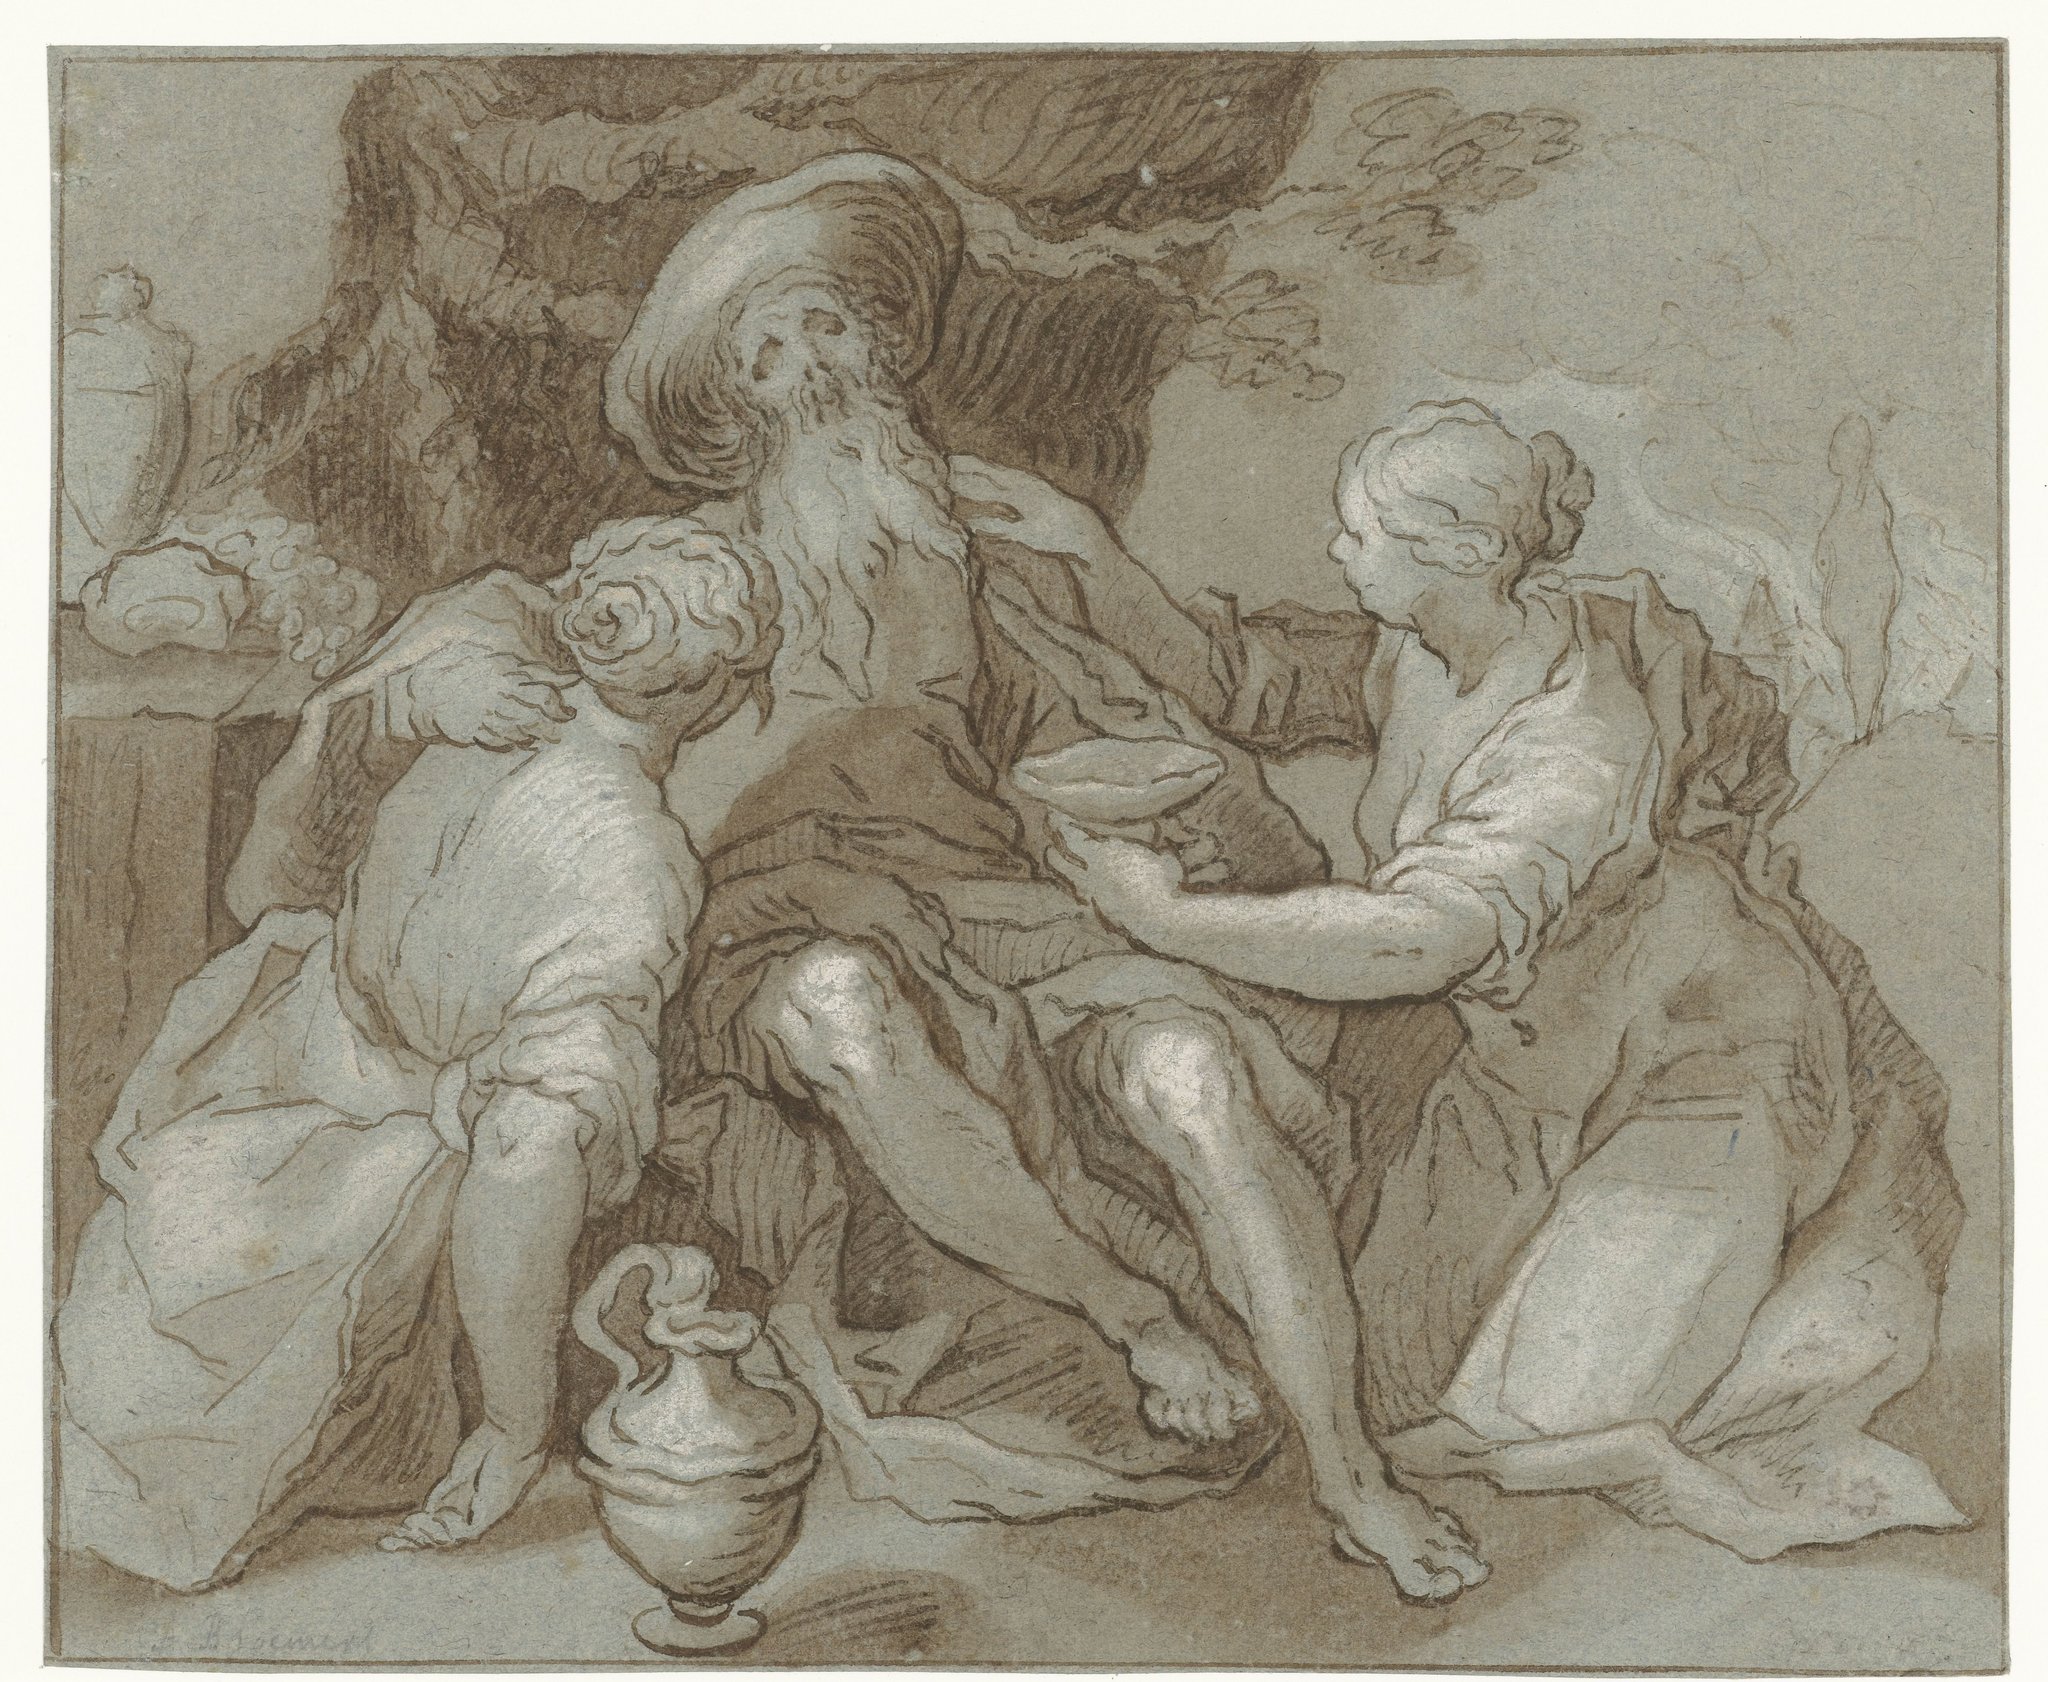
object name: drawing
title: Lot en zijn dochters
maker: Anonymous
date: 1574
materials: ink, paper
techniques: brush, pen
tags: lot and his daughters (genesis 19:30-38)